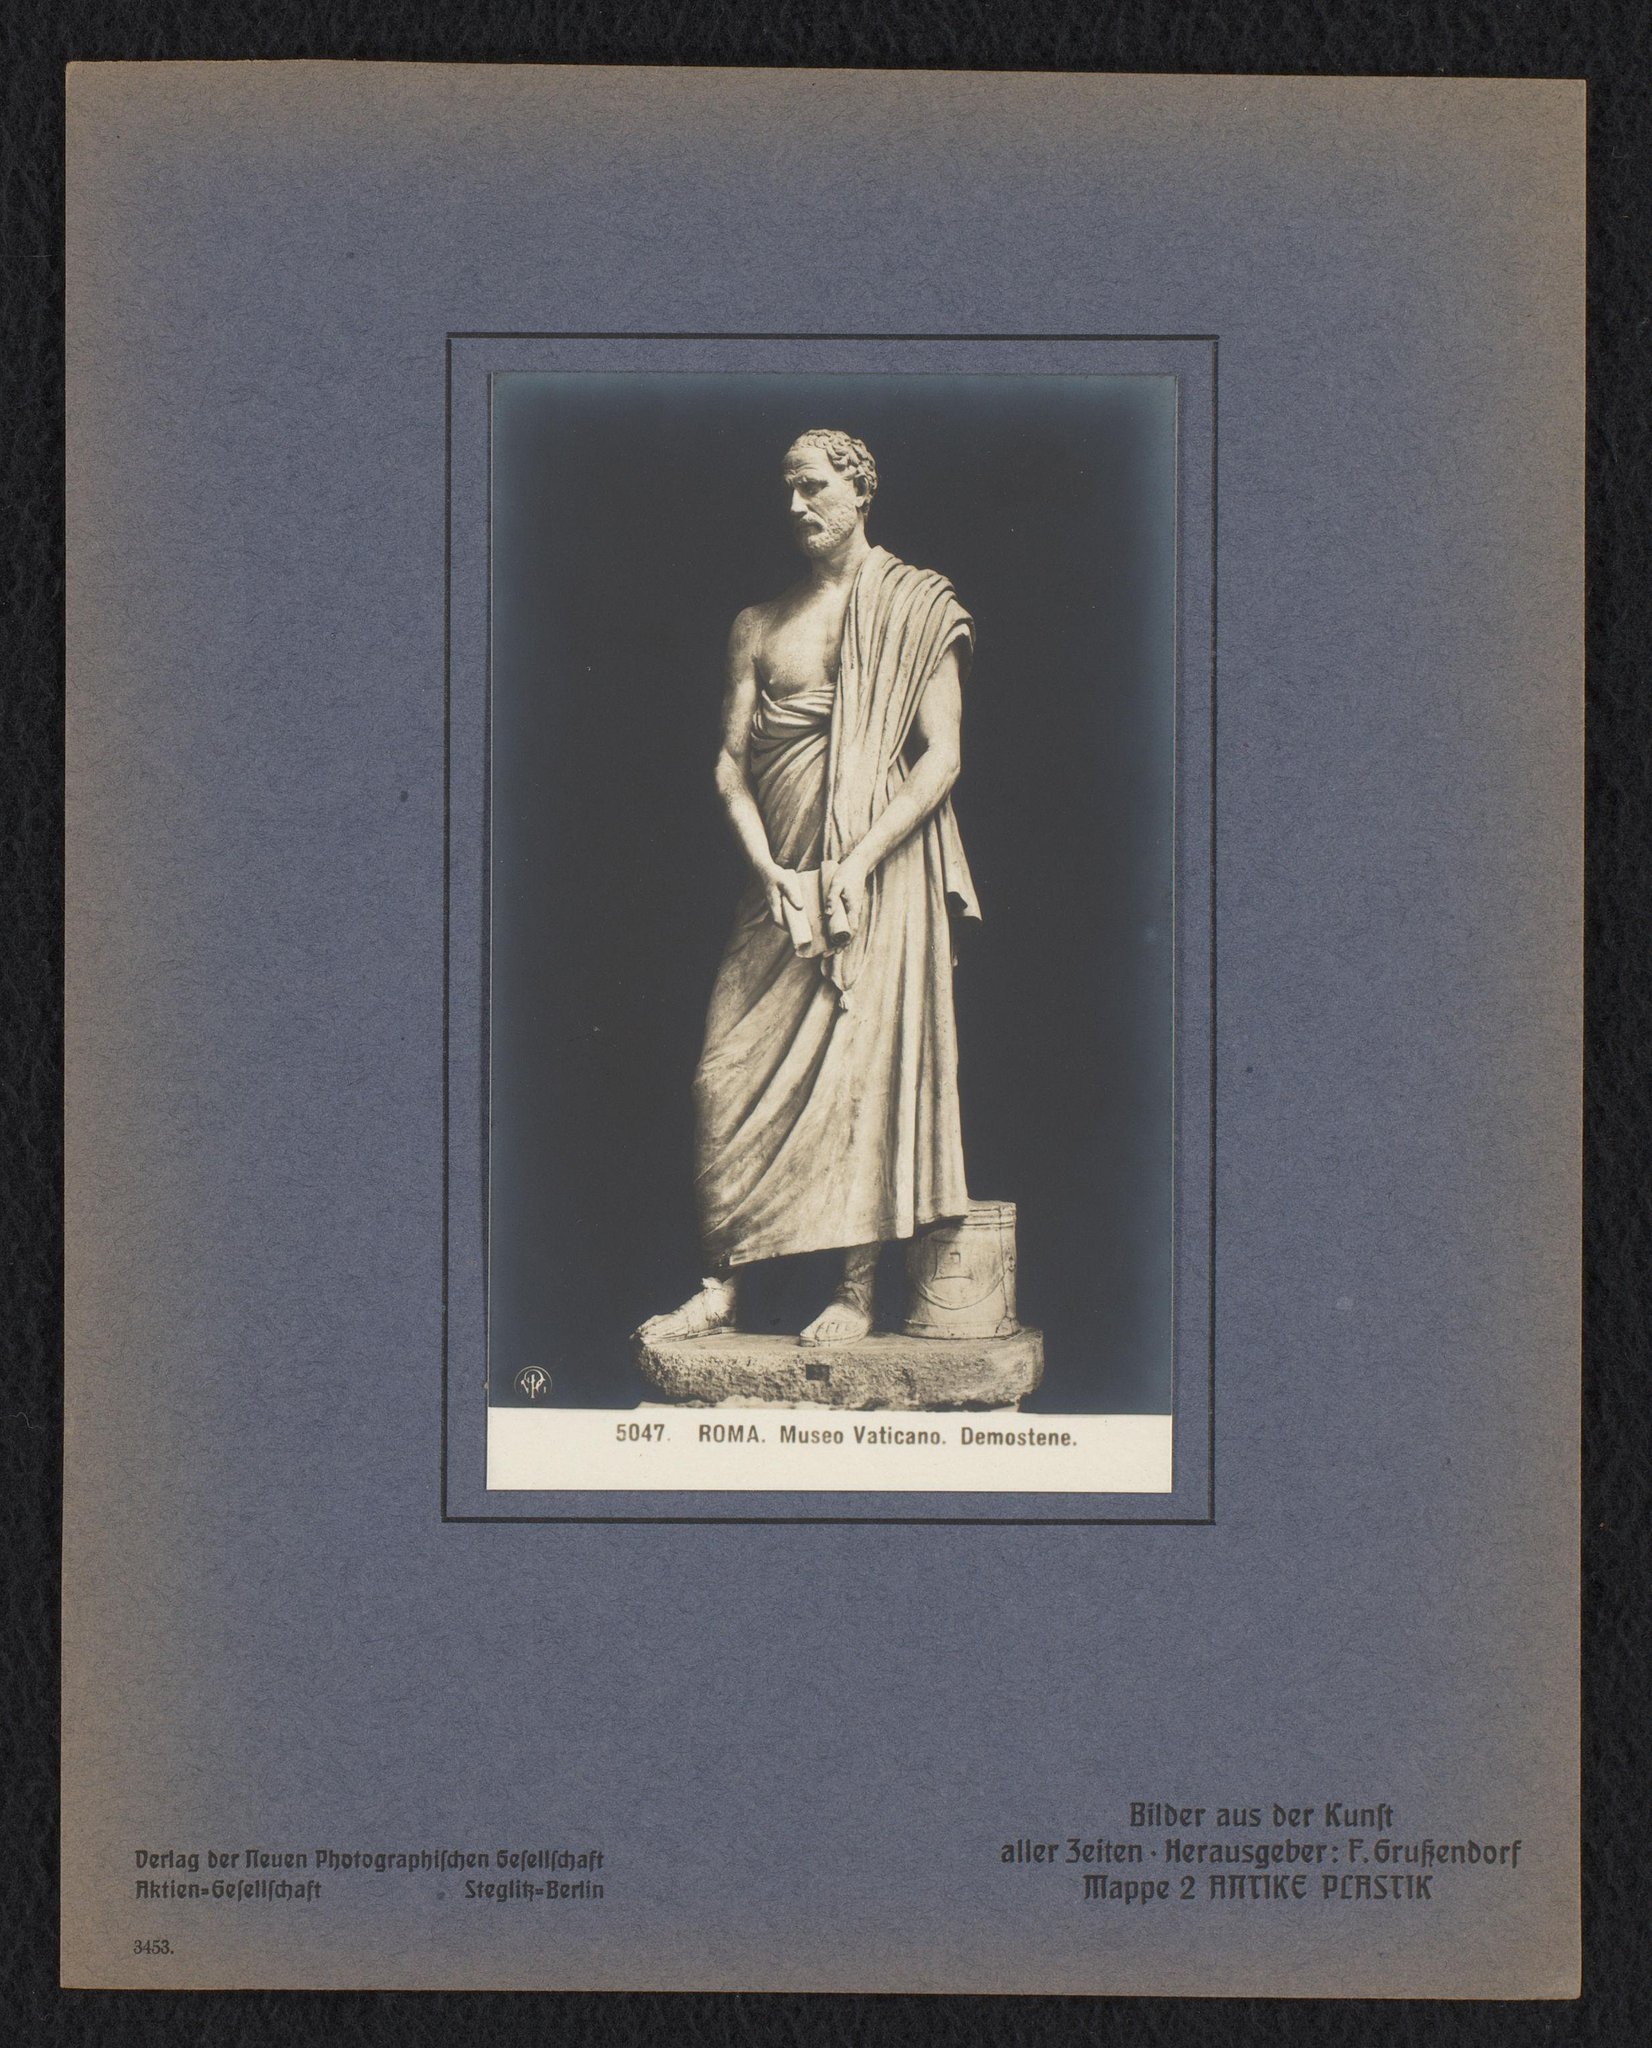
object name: photograph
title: Roma, Museo Vaticano, Demostene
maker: Anonymous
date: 1906-1911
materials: paper, cardboard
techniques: gelatin silver print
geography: steglitz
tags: sculpture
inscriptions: number: ‘5047.’